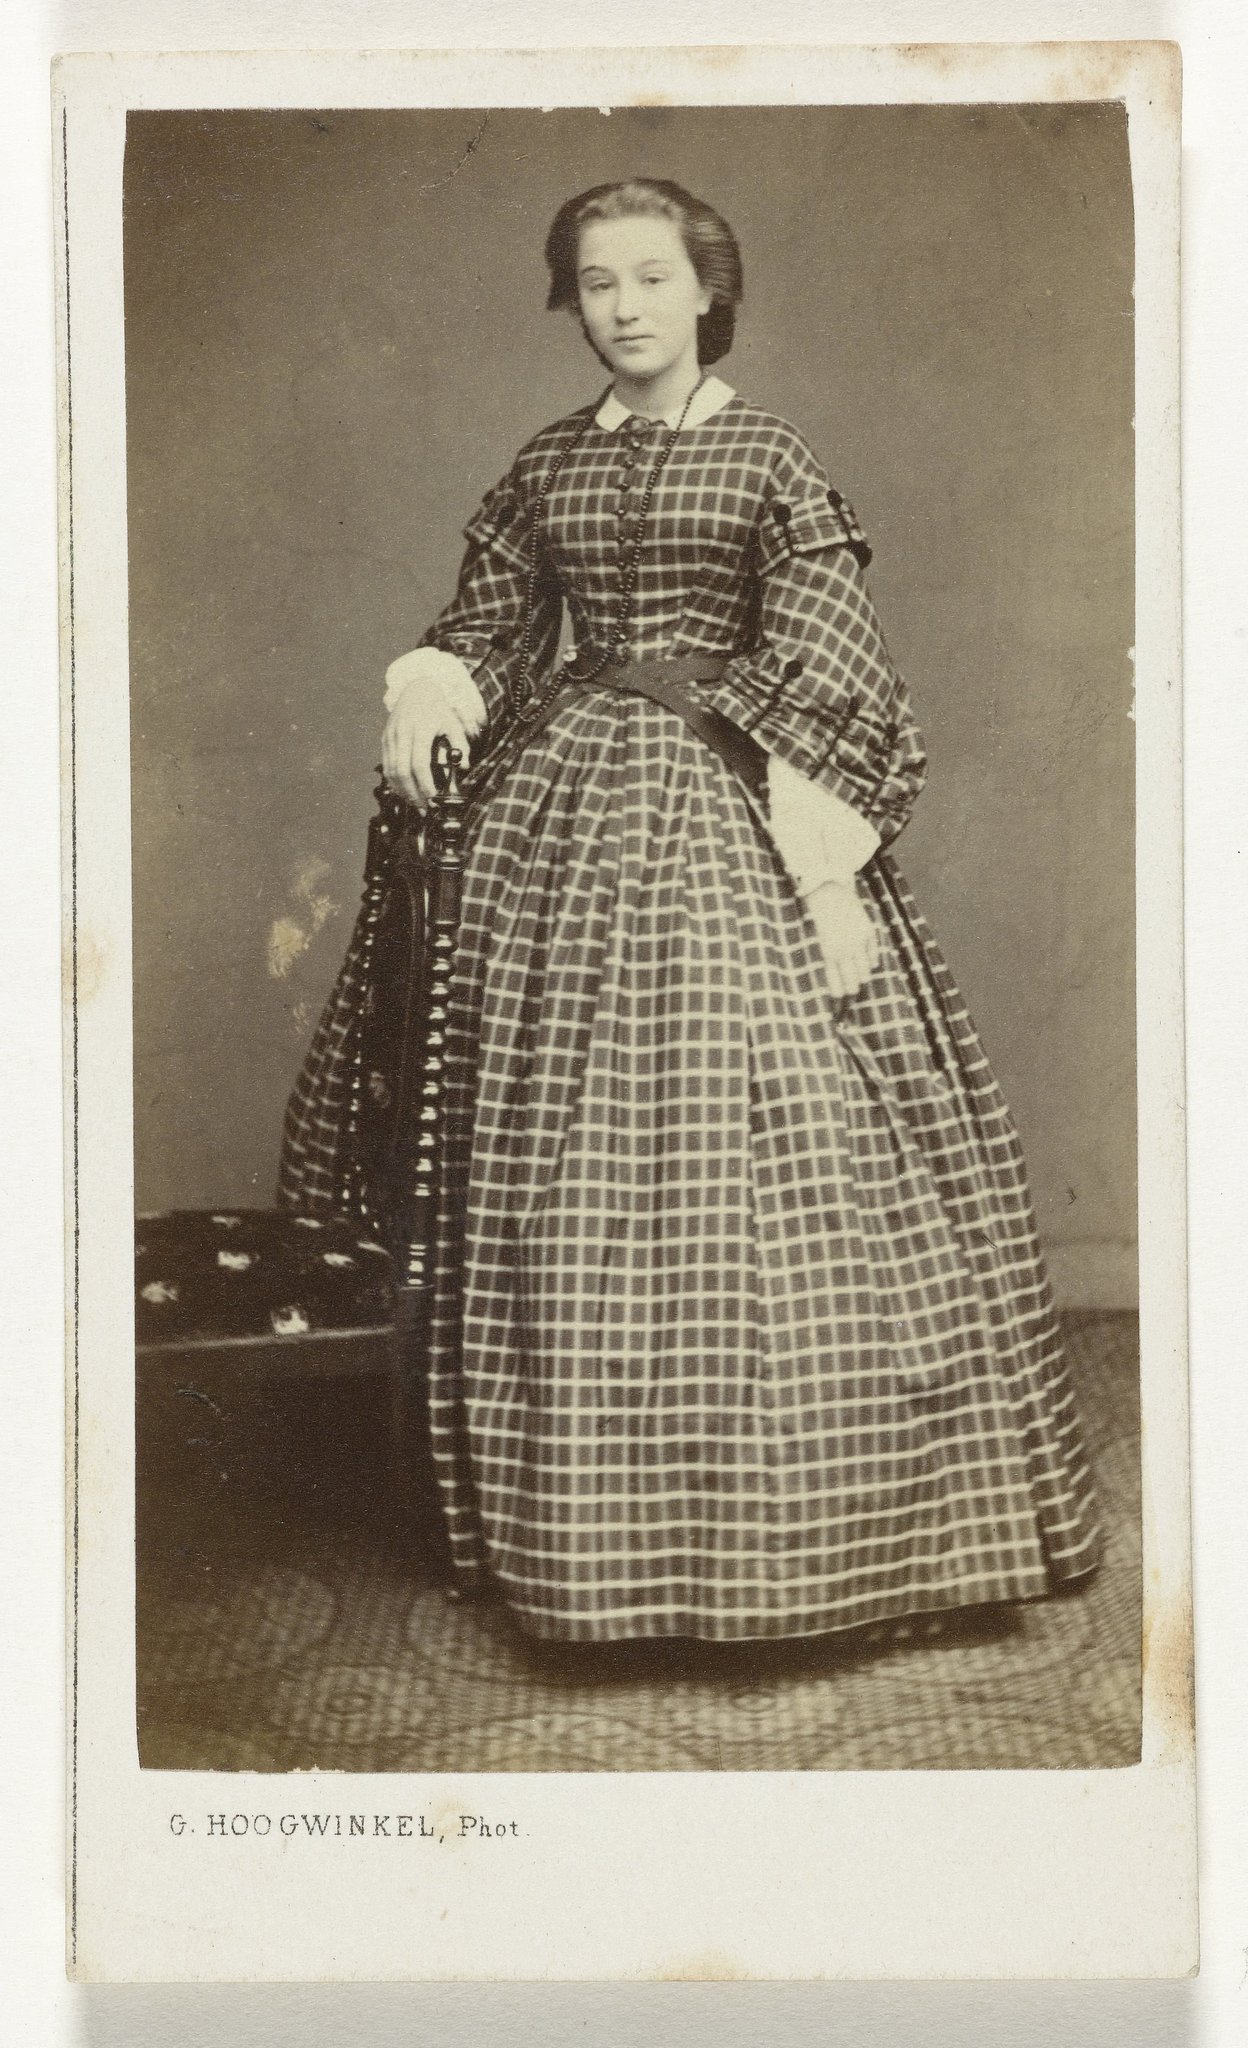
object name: photograph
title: Portret van een vrouw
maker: gerrit hoogwinkel jr.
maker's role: fotograaf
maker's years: 1837-1890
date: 1863-1865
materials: cardboard, paper, photographic support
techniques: albumen print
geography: rotterdam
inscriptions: coat of arms, address: ‘G. Hoogwinkel/Photographe/Rotterdam’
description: Jonge vrouw in een lange, geruite japon, staand naast een stoel, met haar hand op de rugleuning.